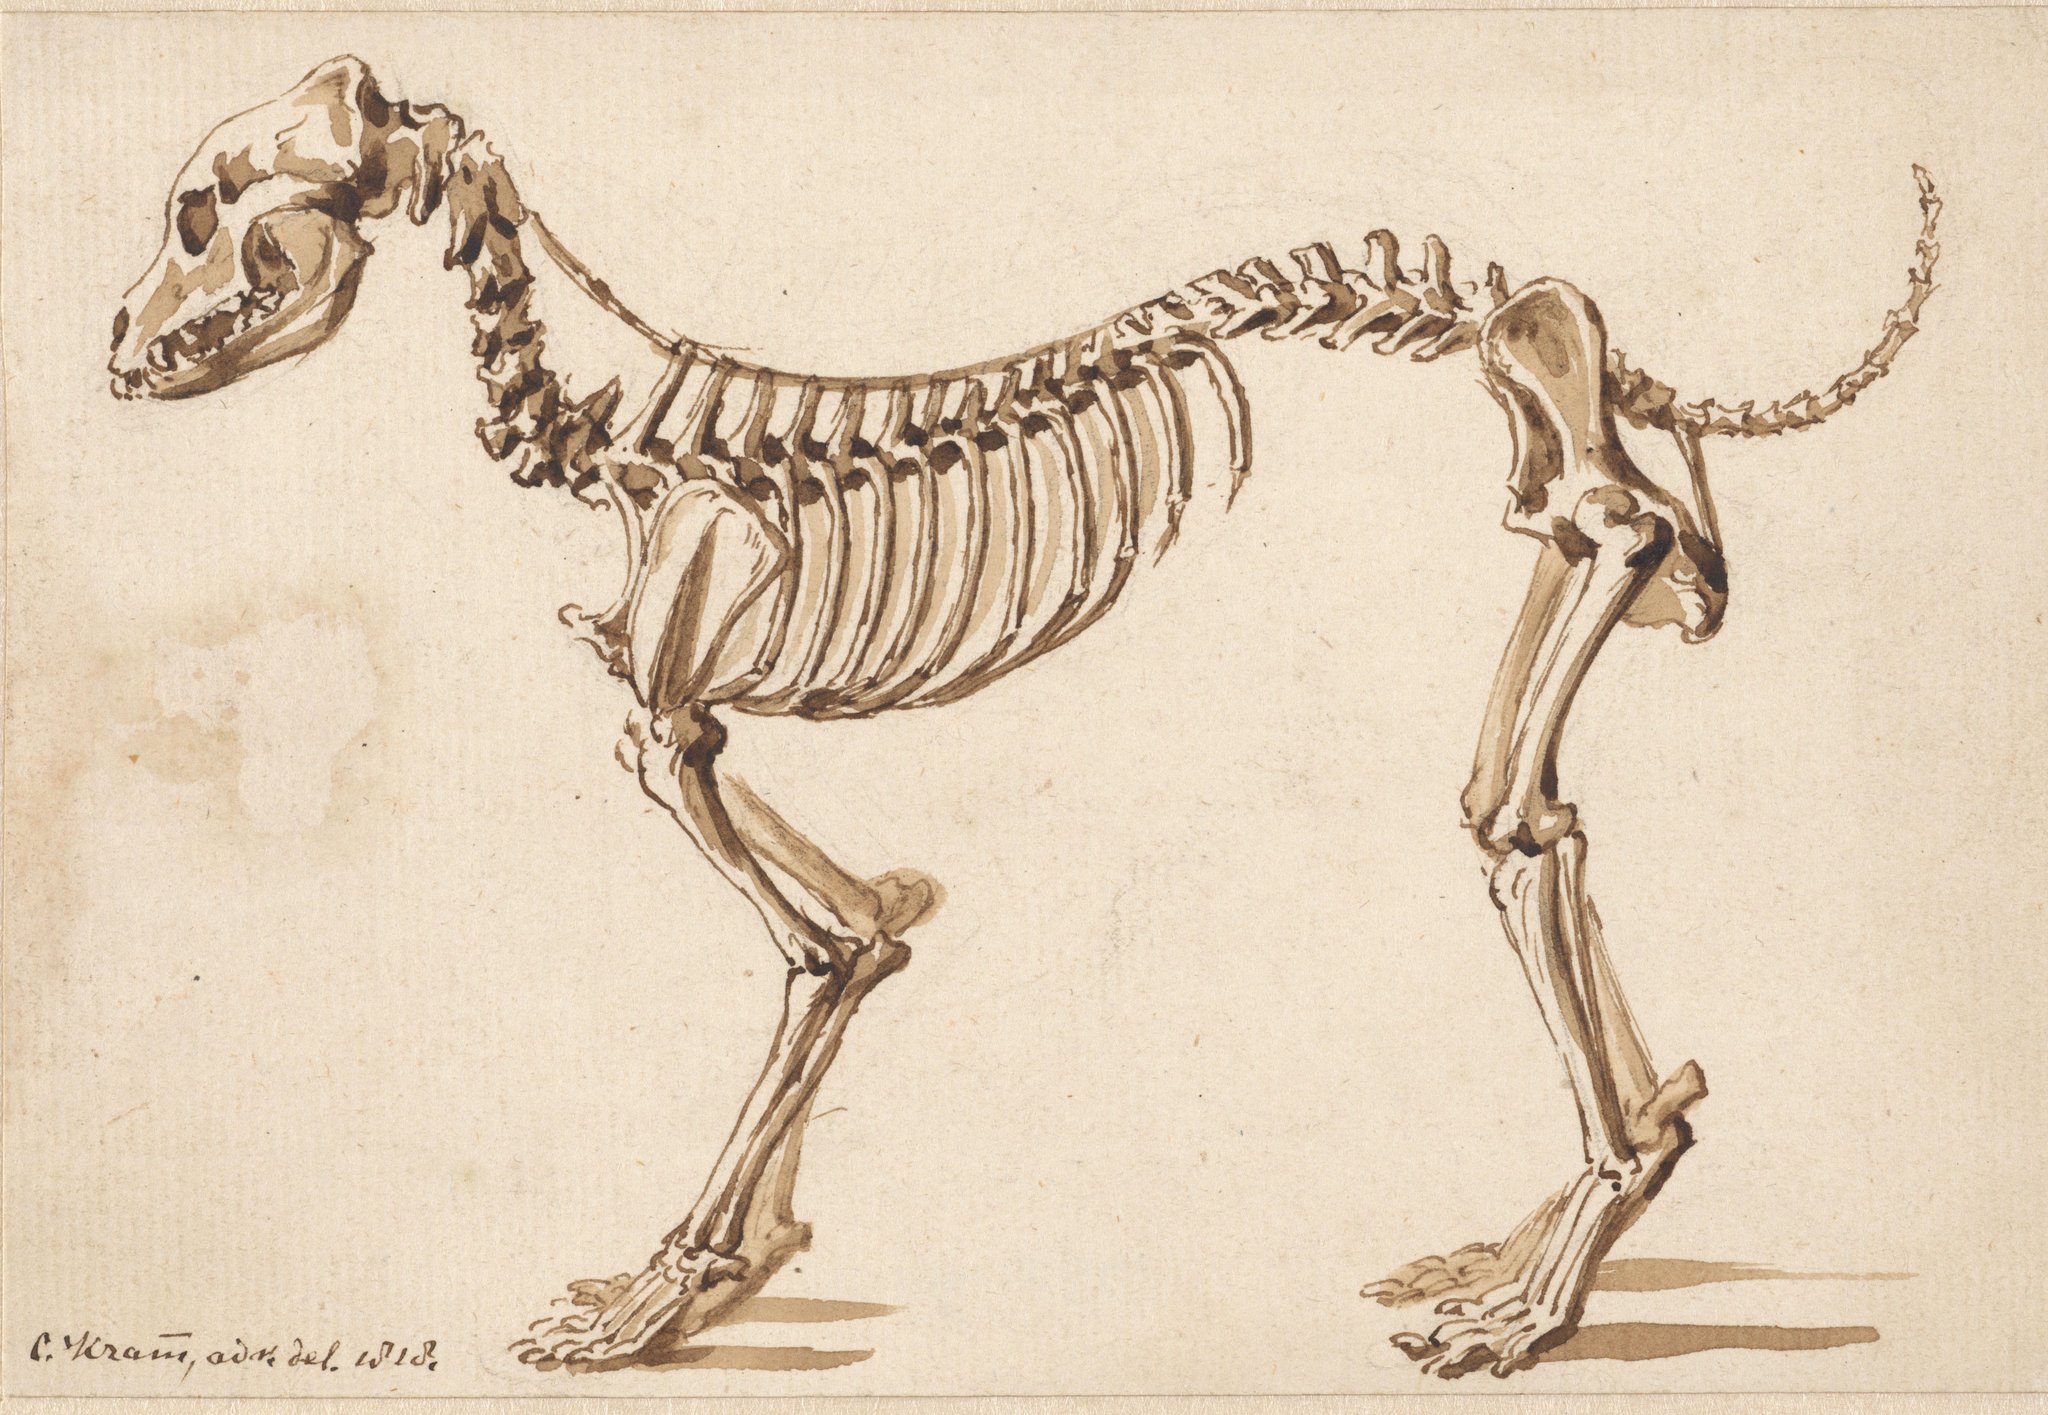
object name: drawing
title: Skelet van een hond van opzij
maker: christiaan kramm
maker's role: draughtsman, print maker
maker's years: 1797-1875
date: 1797-1875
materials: paper, pencil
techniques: brush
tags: dog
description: Skelet van een hond van opzij. Samen met nog een skelet van een hond van opzij (RP-T-1993-93(B)) op één opzetkarton.